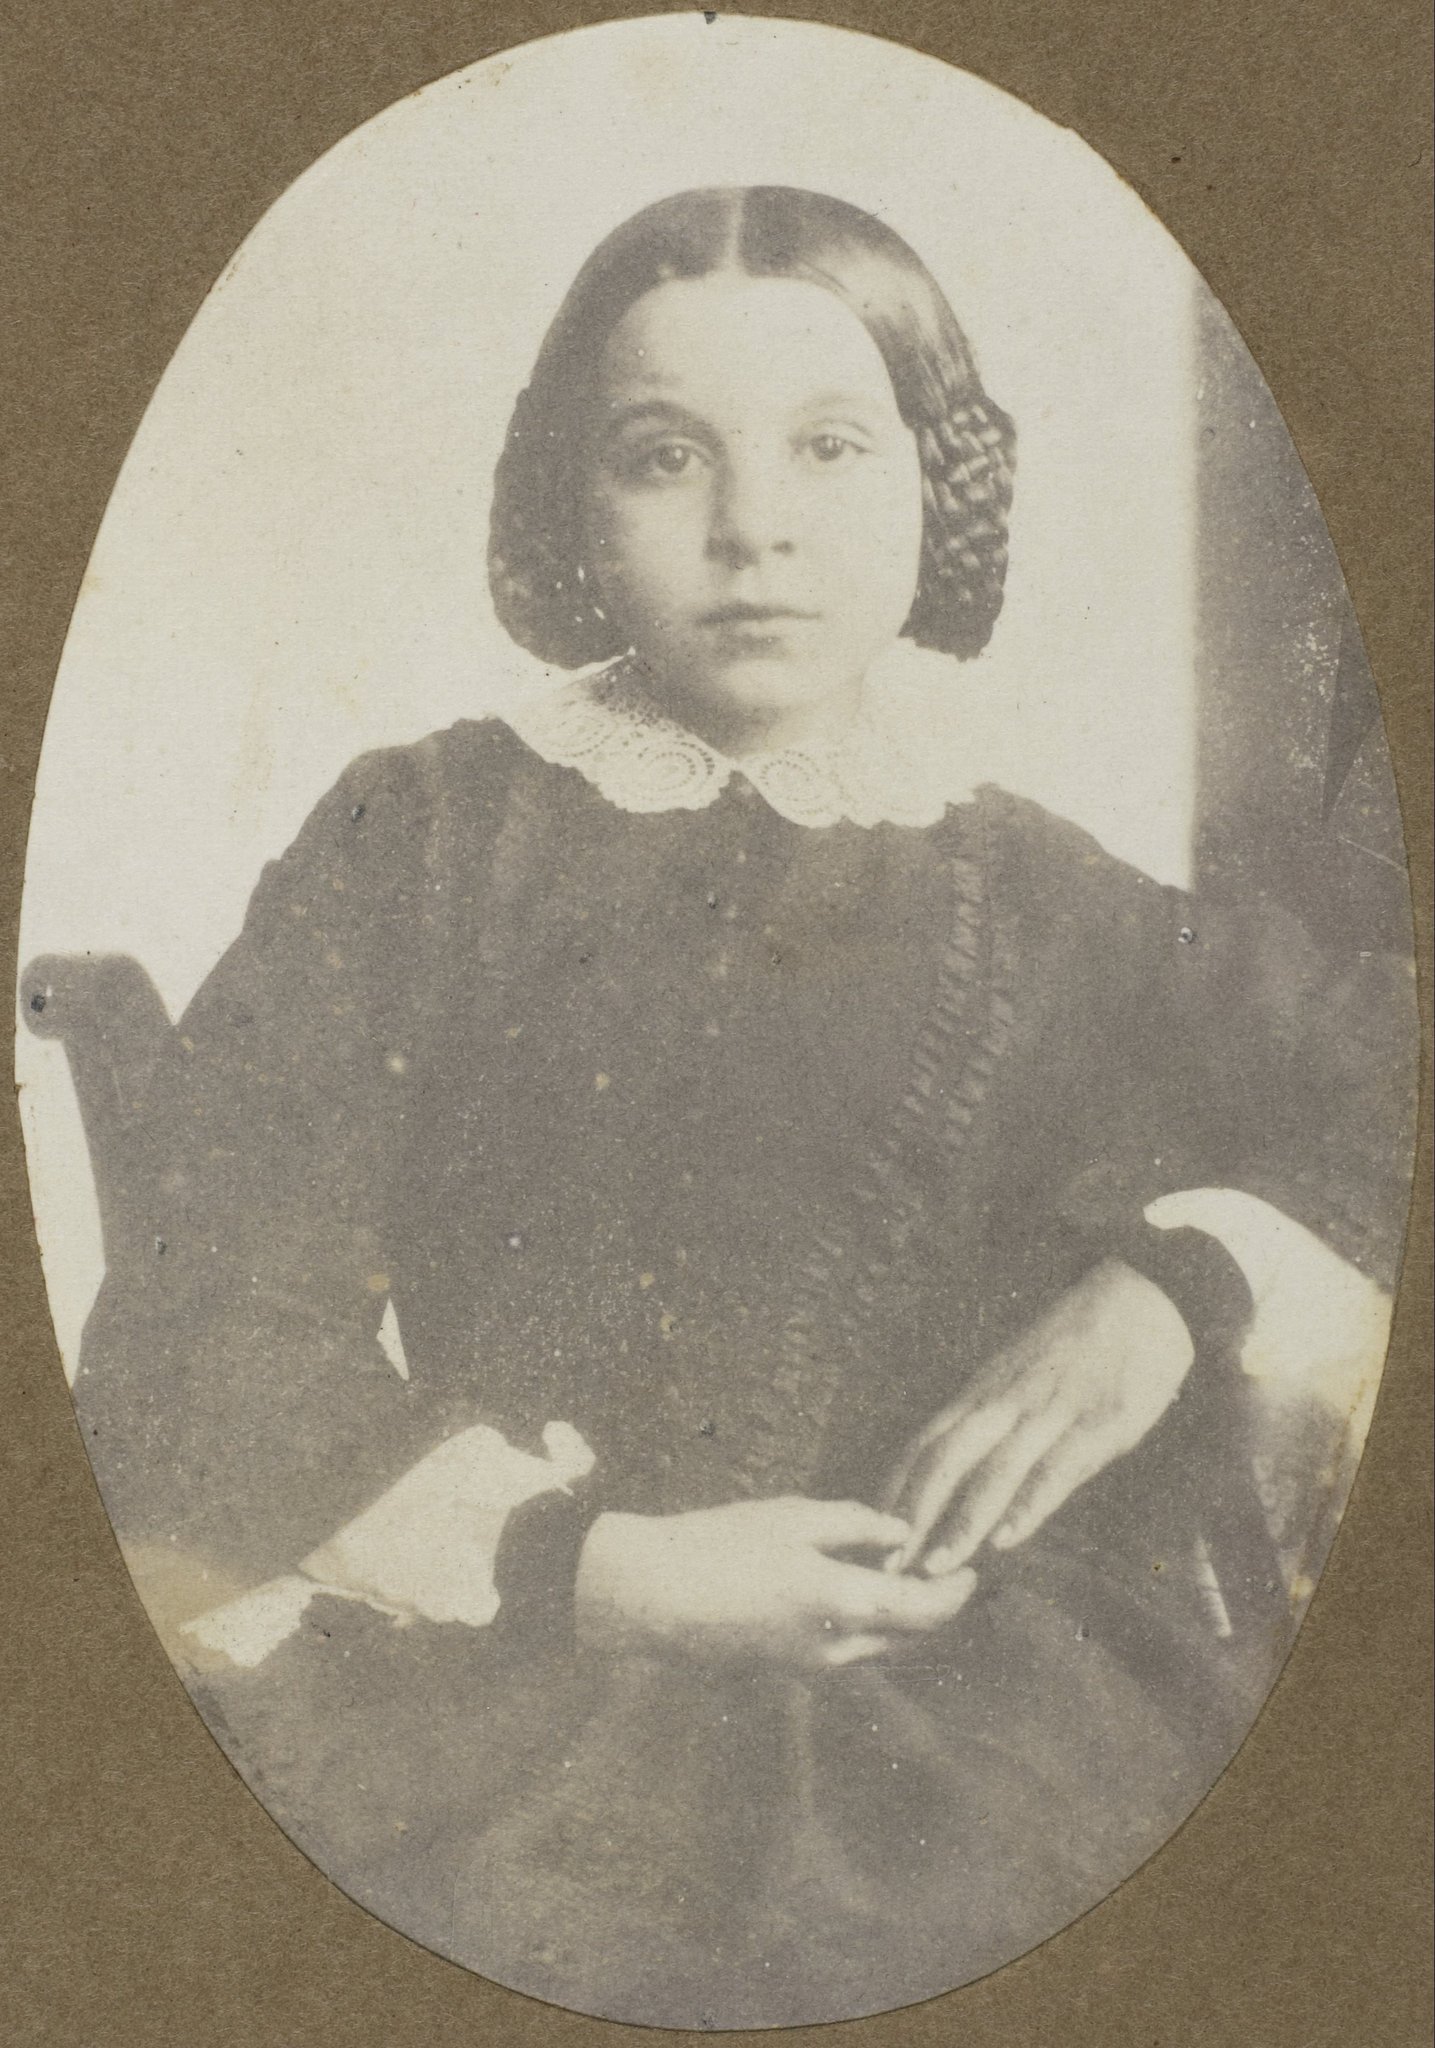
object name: photograph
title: Portret van een meisje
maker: eduard isaac asser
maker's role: amateurfotograaf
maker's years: 1809-1894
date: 1852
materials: cardboard, paper, photographic support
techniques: salted paper print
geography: amsterdam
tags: anonymous historical person portrayed alone - bb - woman, netherlands